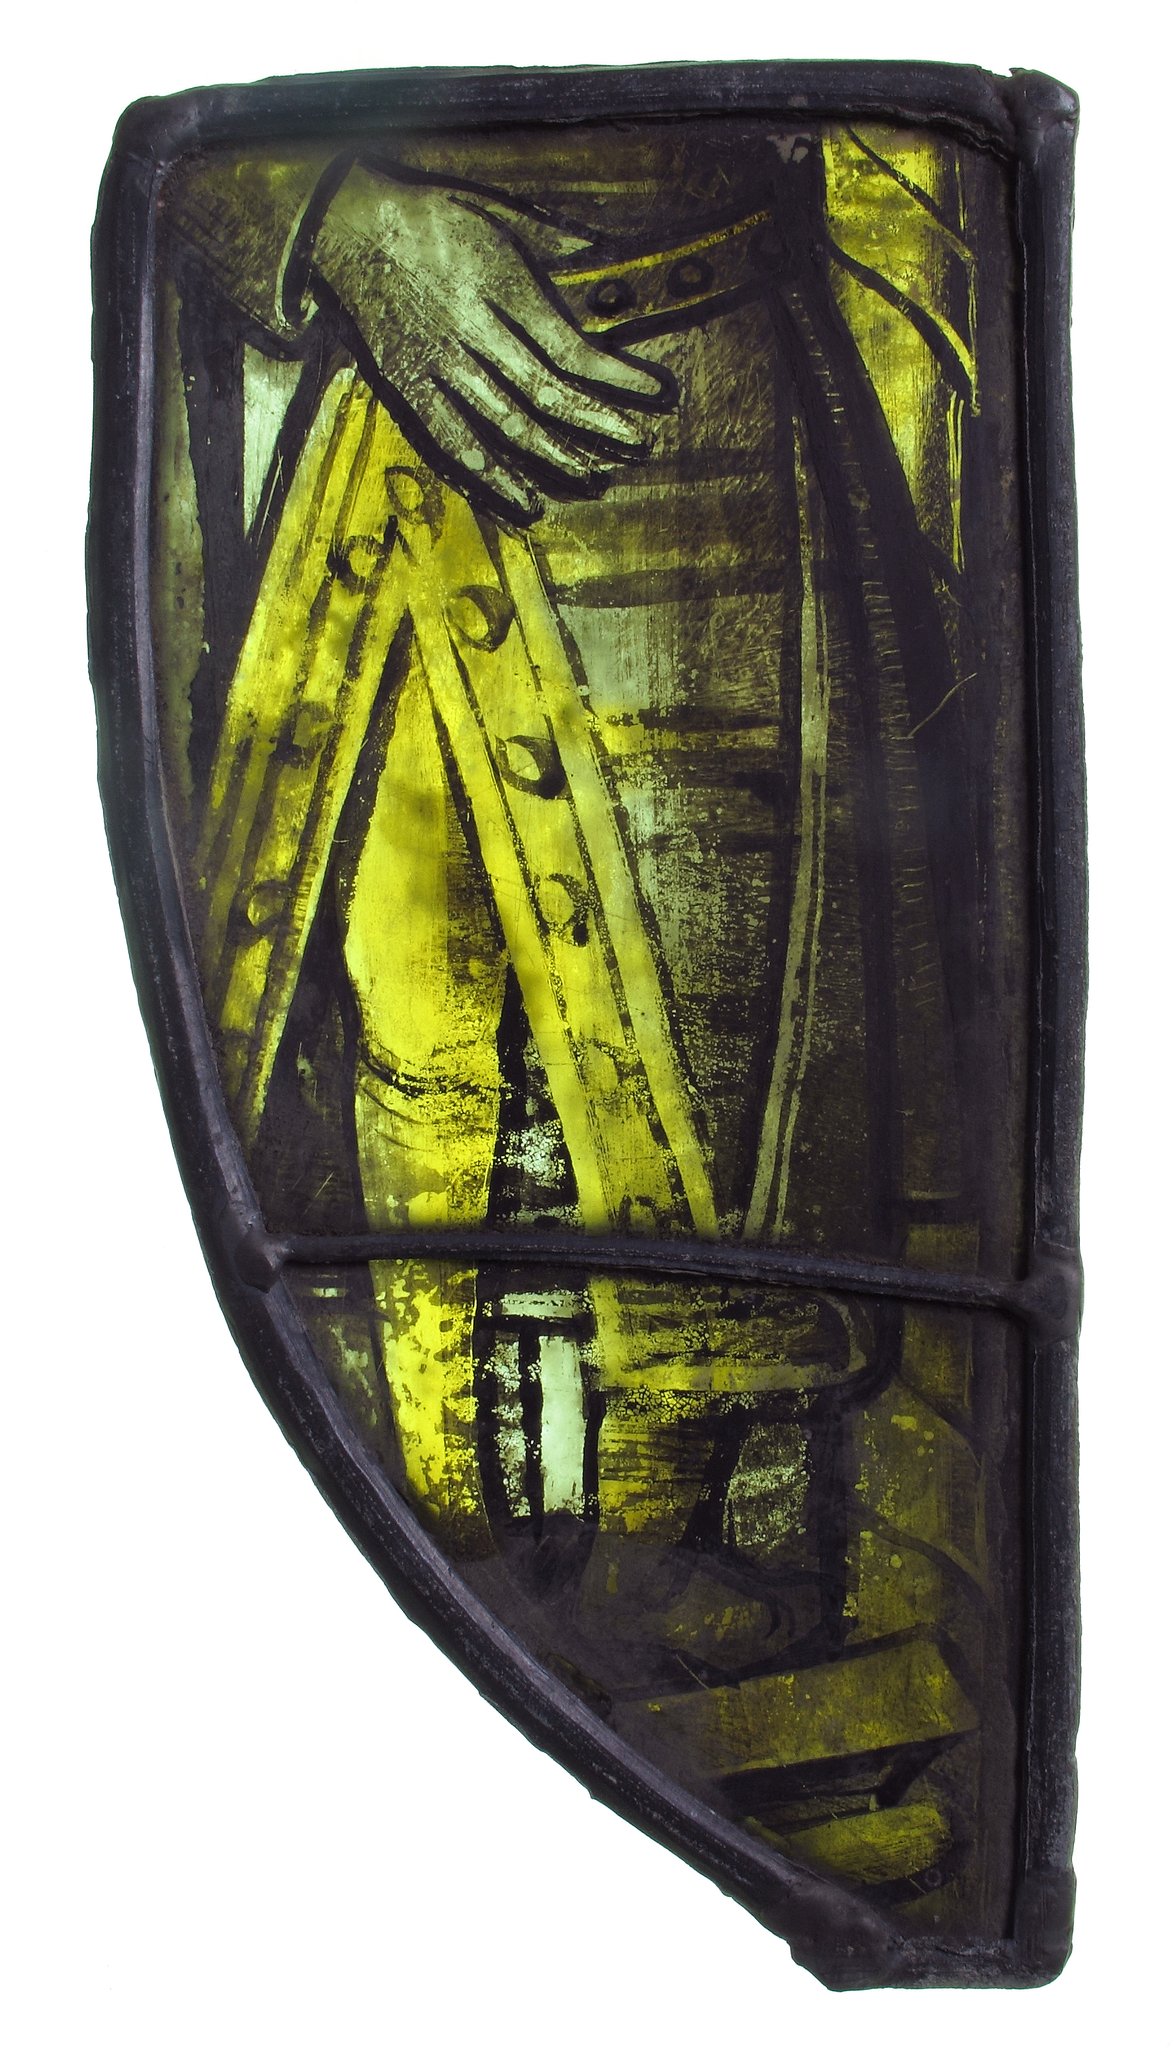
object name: fragment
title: Glass Fragment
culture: european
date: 1401-1600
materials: glass, paint, pigment